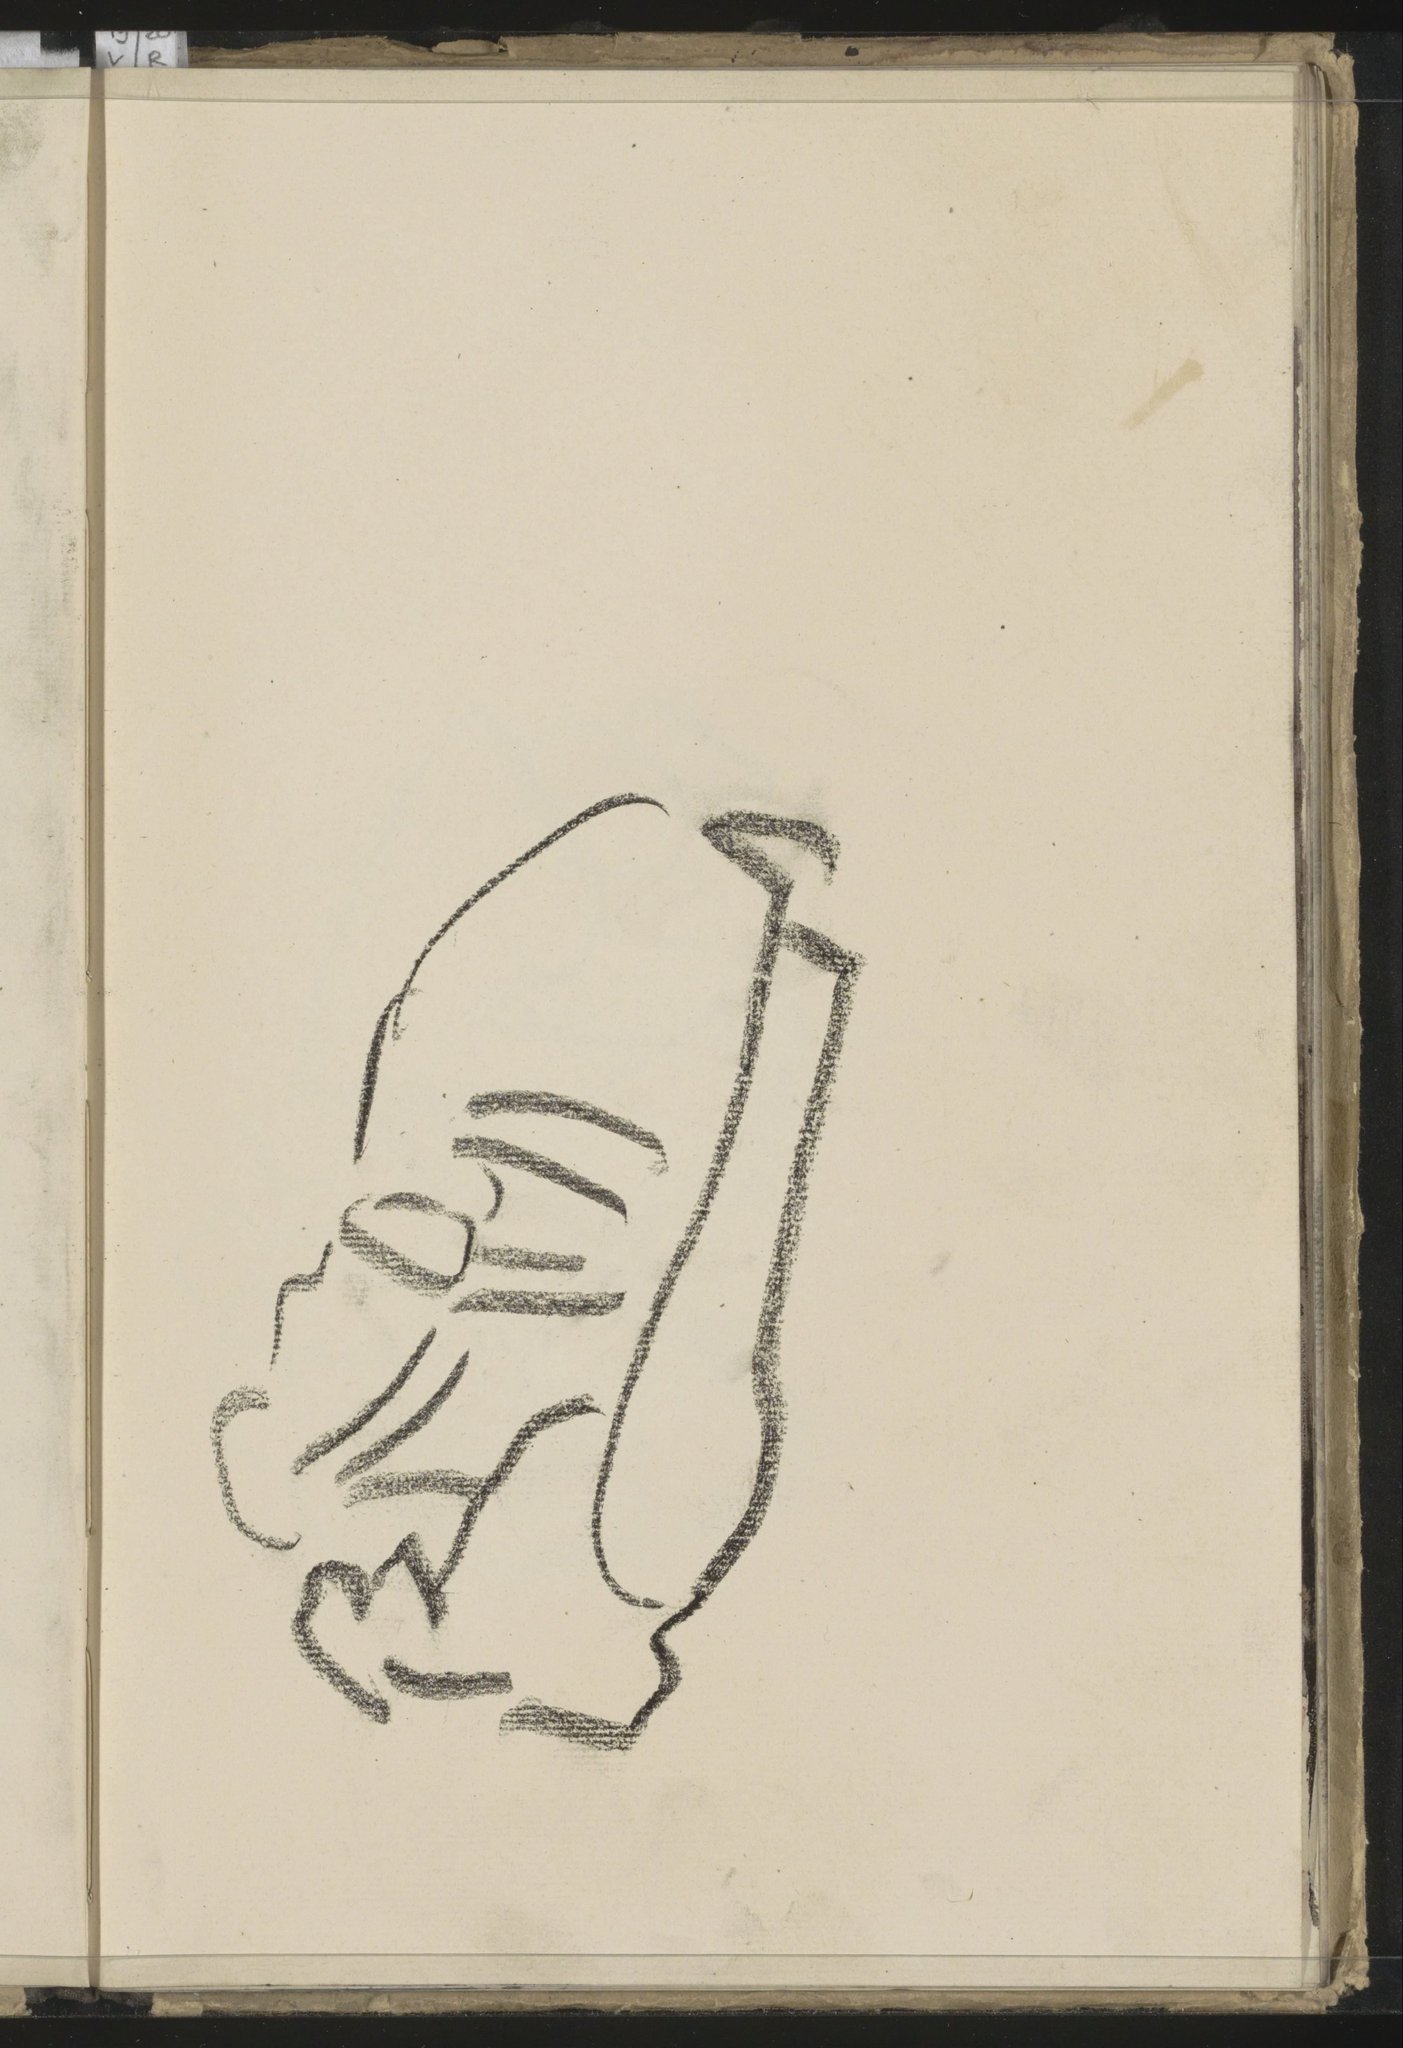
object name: sketchbook leaf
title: Studie, mogelijk een figuur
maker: carel adolph lion cachet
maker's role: draughtsman, print maker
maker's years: 1864-1945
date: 1890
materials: chalk, paper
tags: anatomy (non-medical)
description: Blad 15 recto uit een schetsboek met 38 bladen.